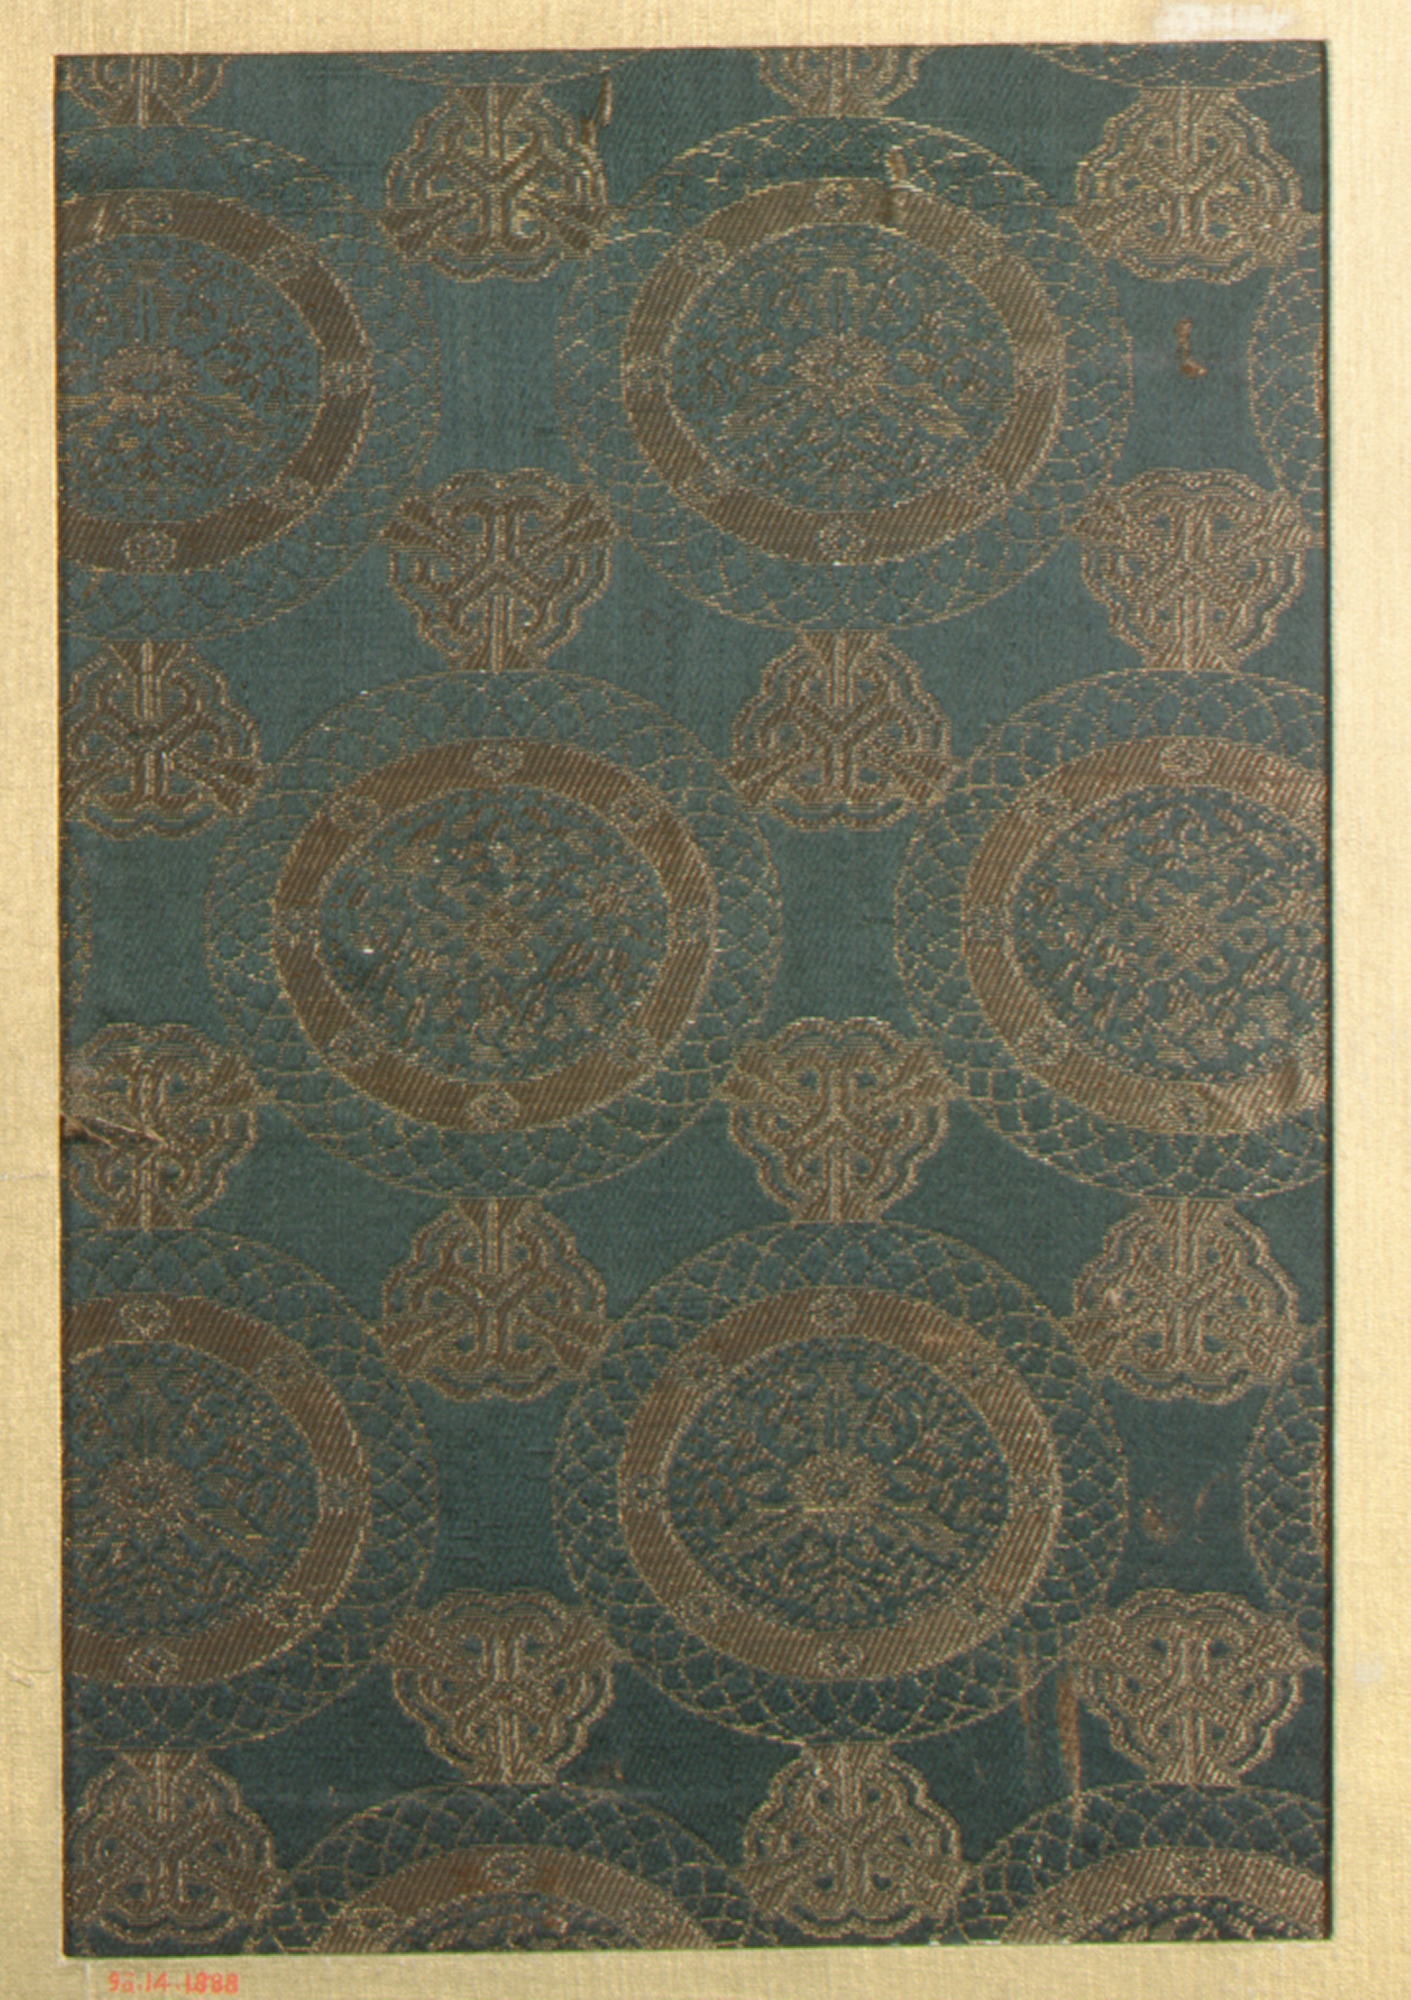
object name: piece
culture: japanese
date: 1701-1900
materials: silk